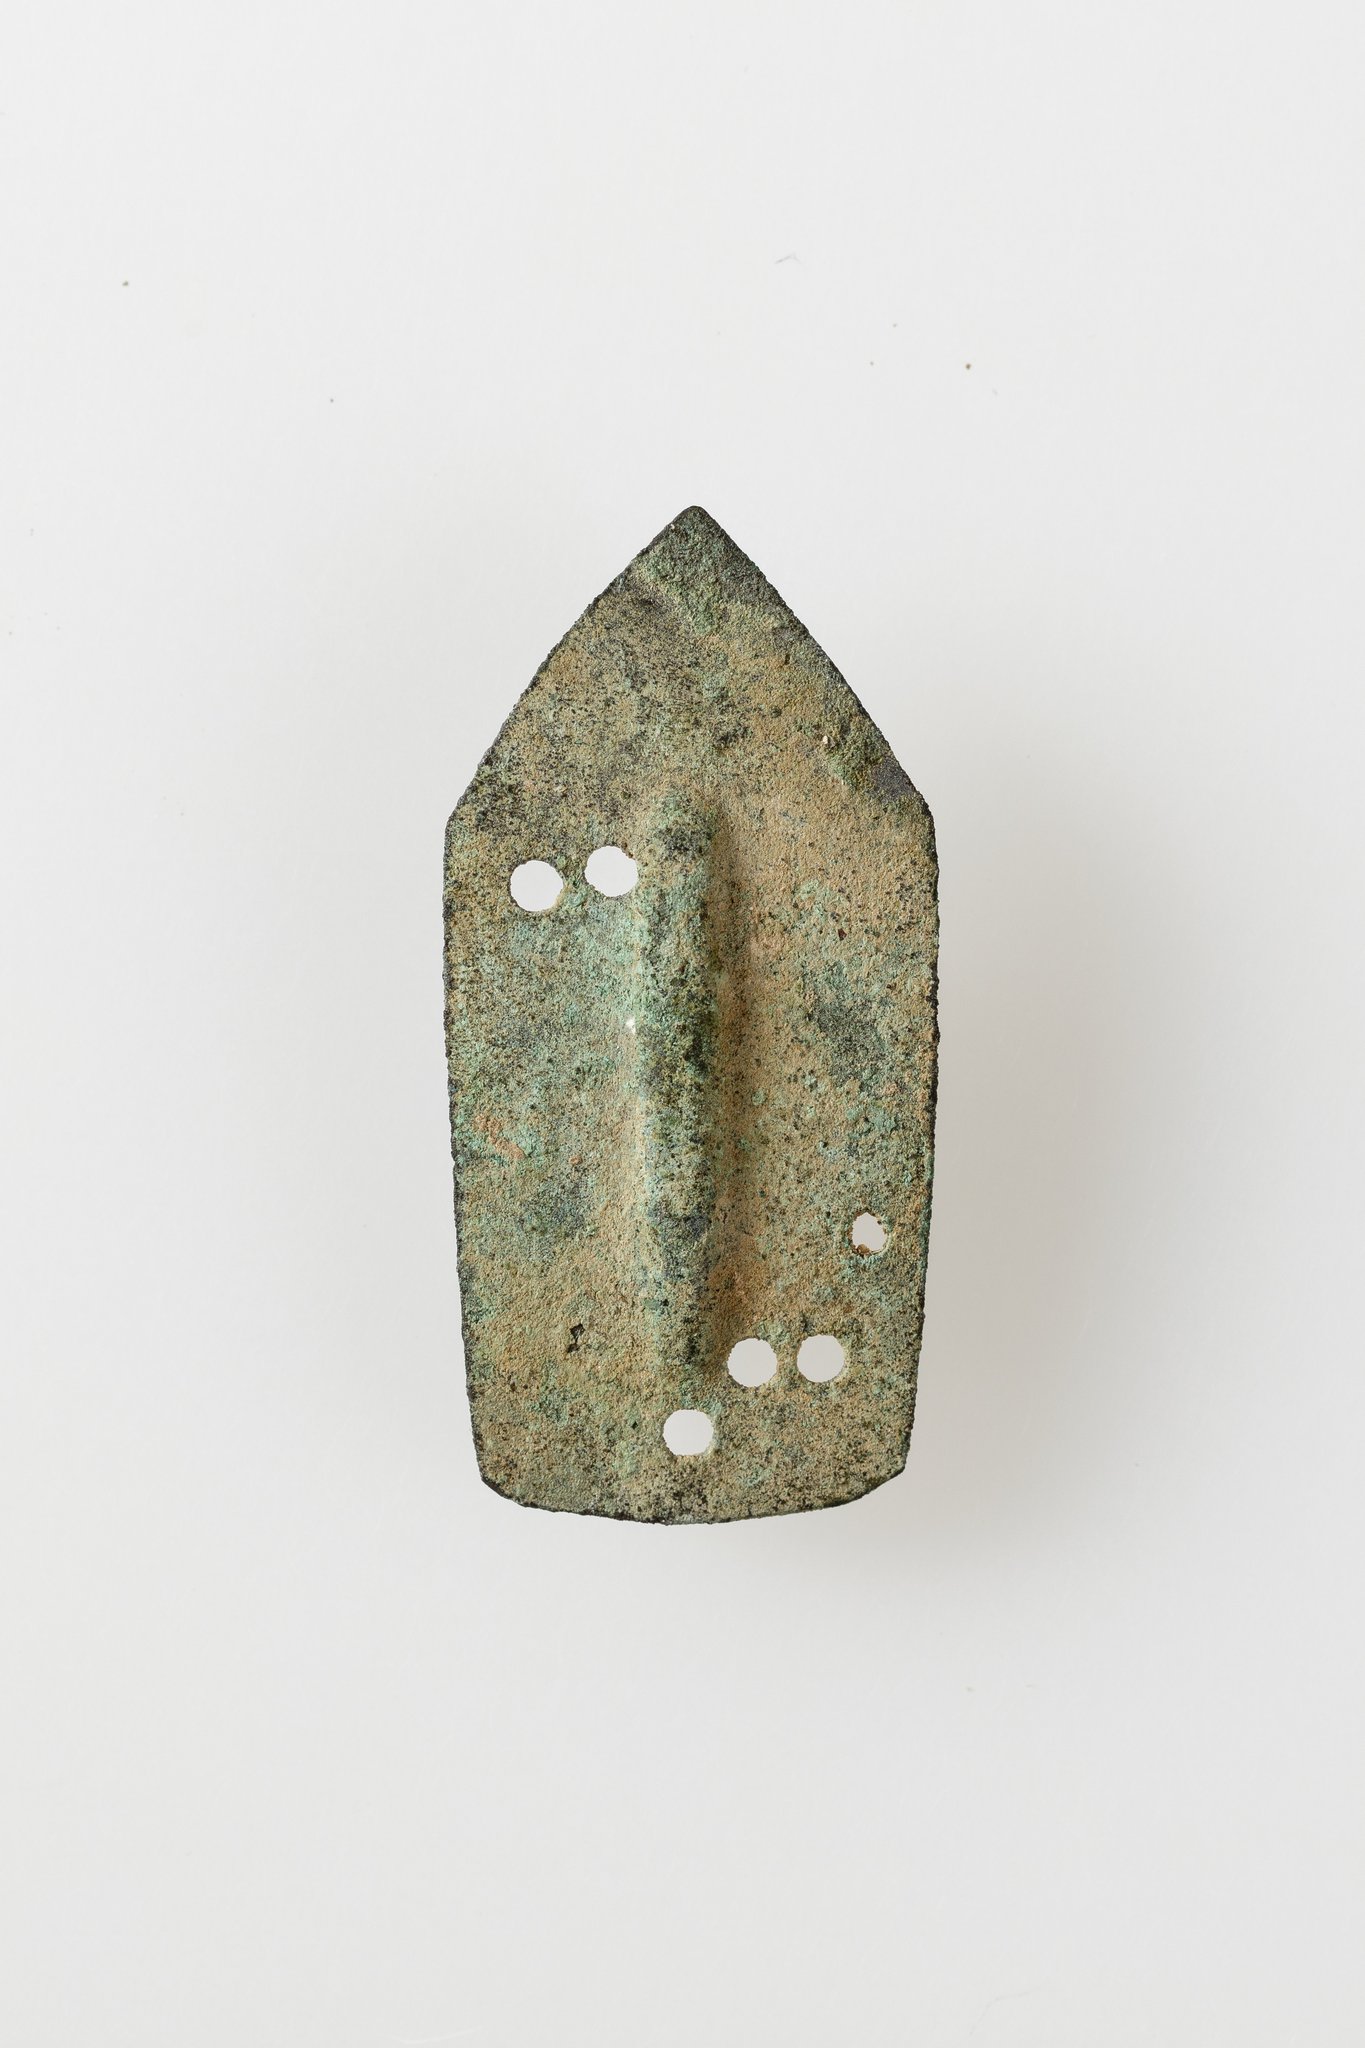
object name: armor scale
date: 664-332 BCE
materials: bronze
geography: egypt